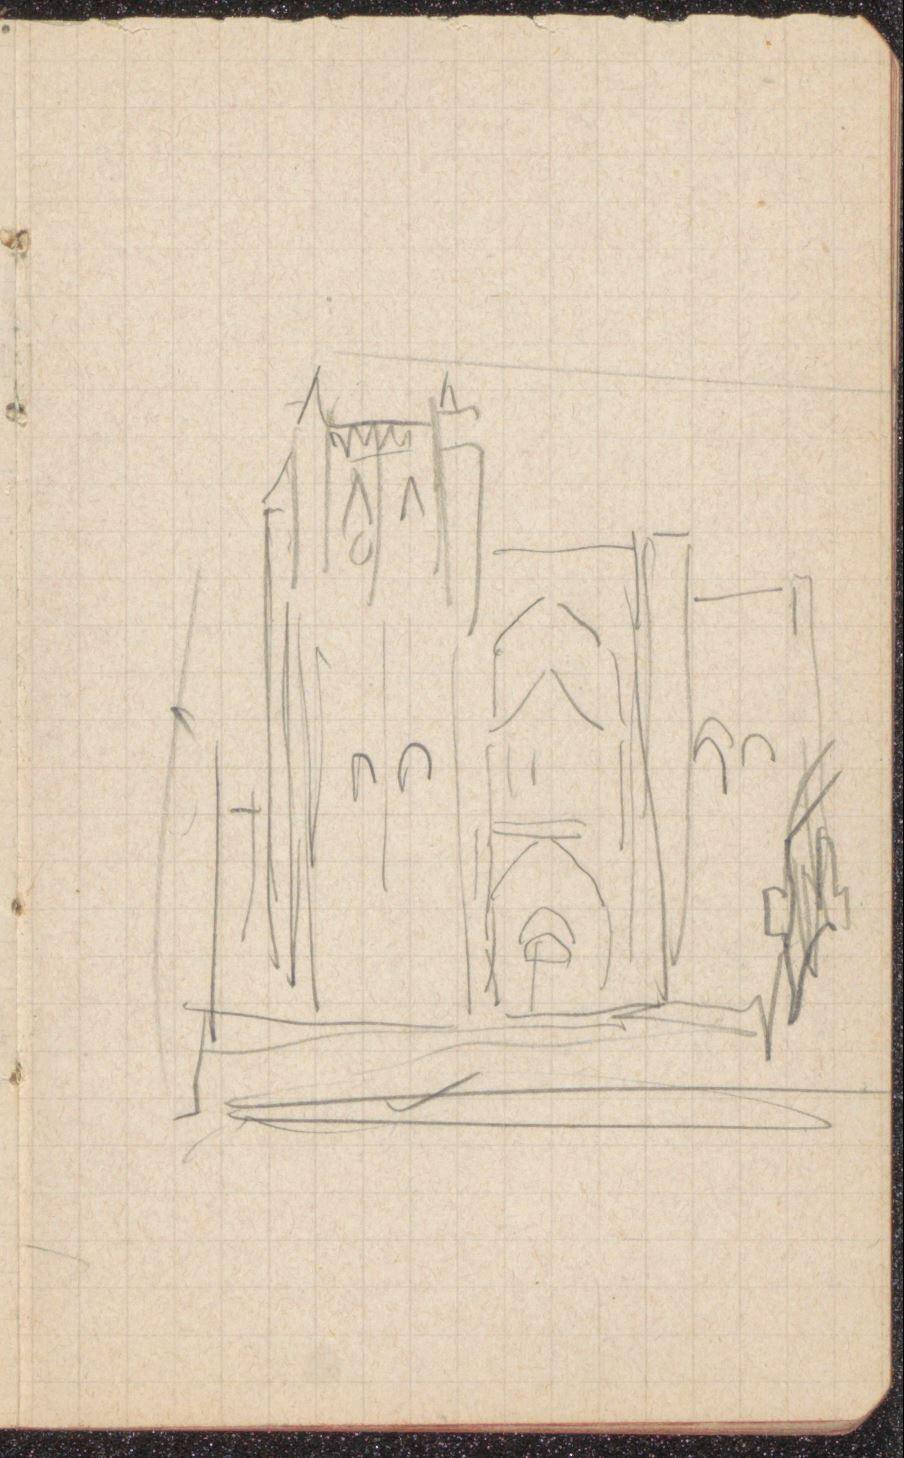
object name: sketchbook leaf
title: Vooraanzicht van de kathedraal van Ávila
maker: marius bauer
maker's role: draughtsman, print maker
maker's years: 1867-1932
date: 1902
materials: pencil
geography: avila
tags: riding a horse, ass, or mule; rider, horseman, church (exterior)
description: Pagina 13 uit een schetsboek met 23 bladen.